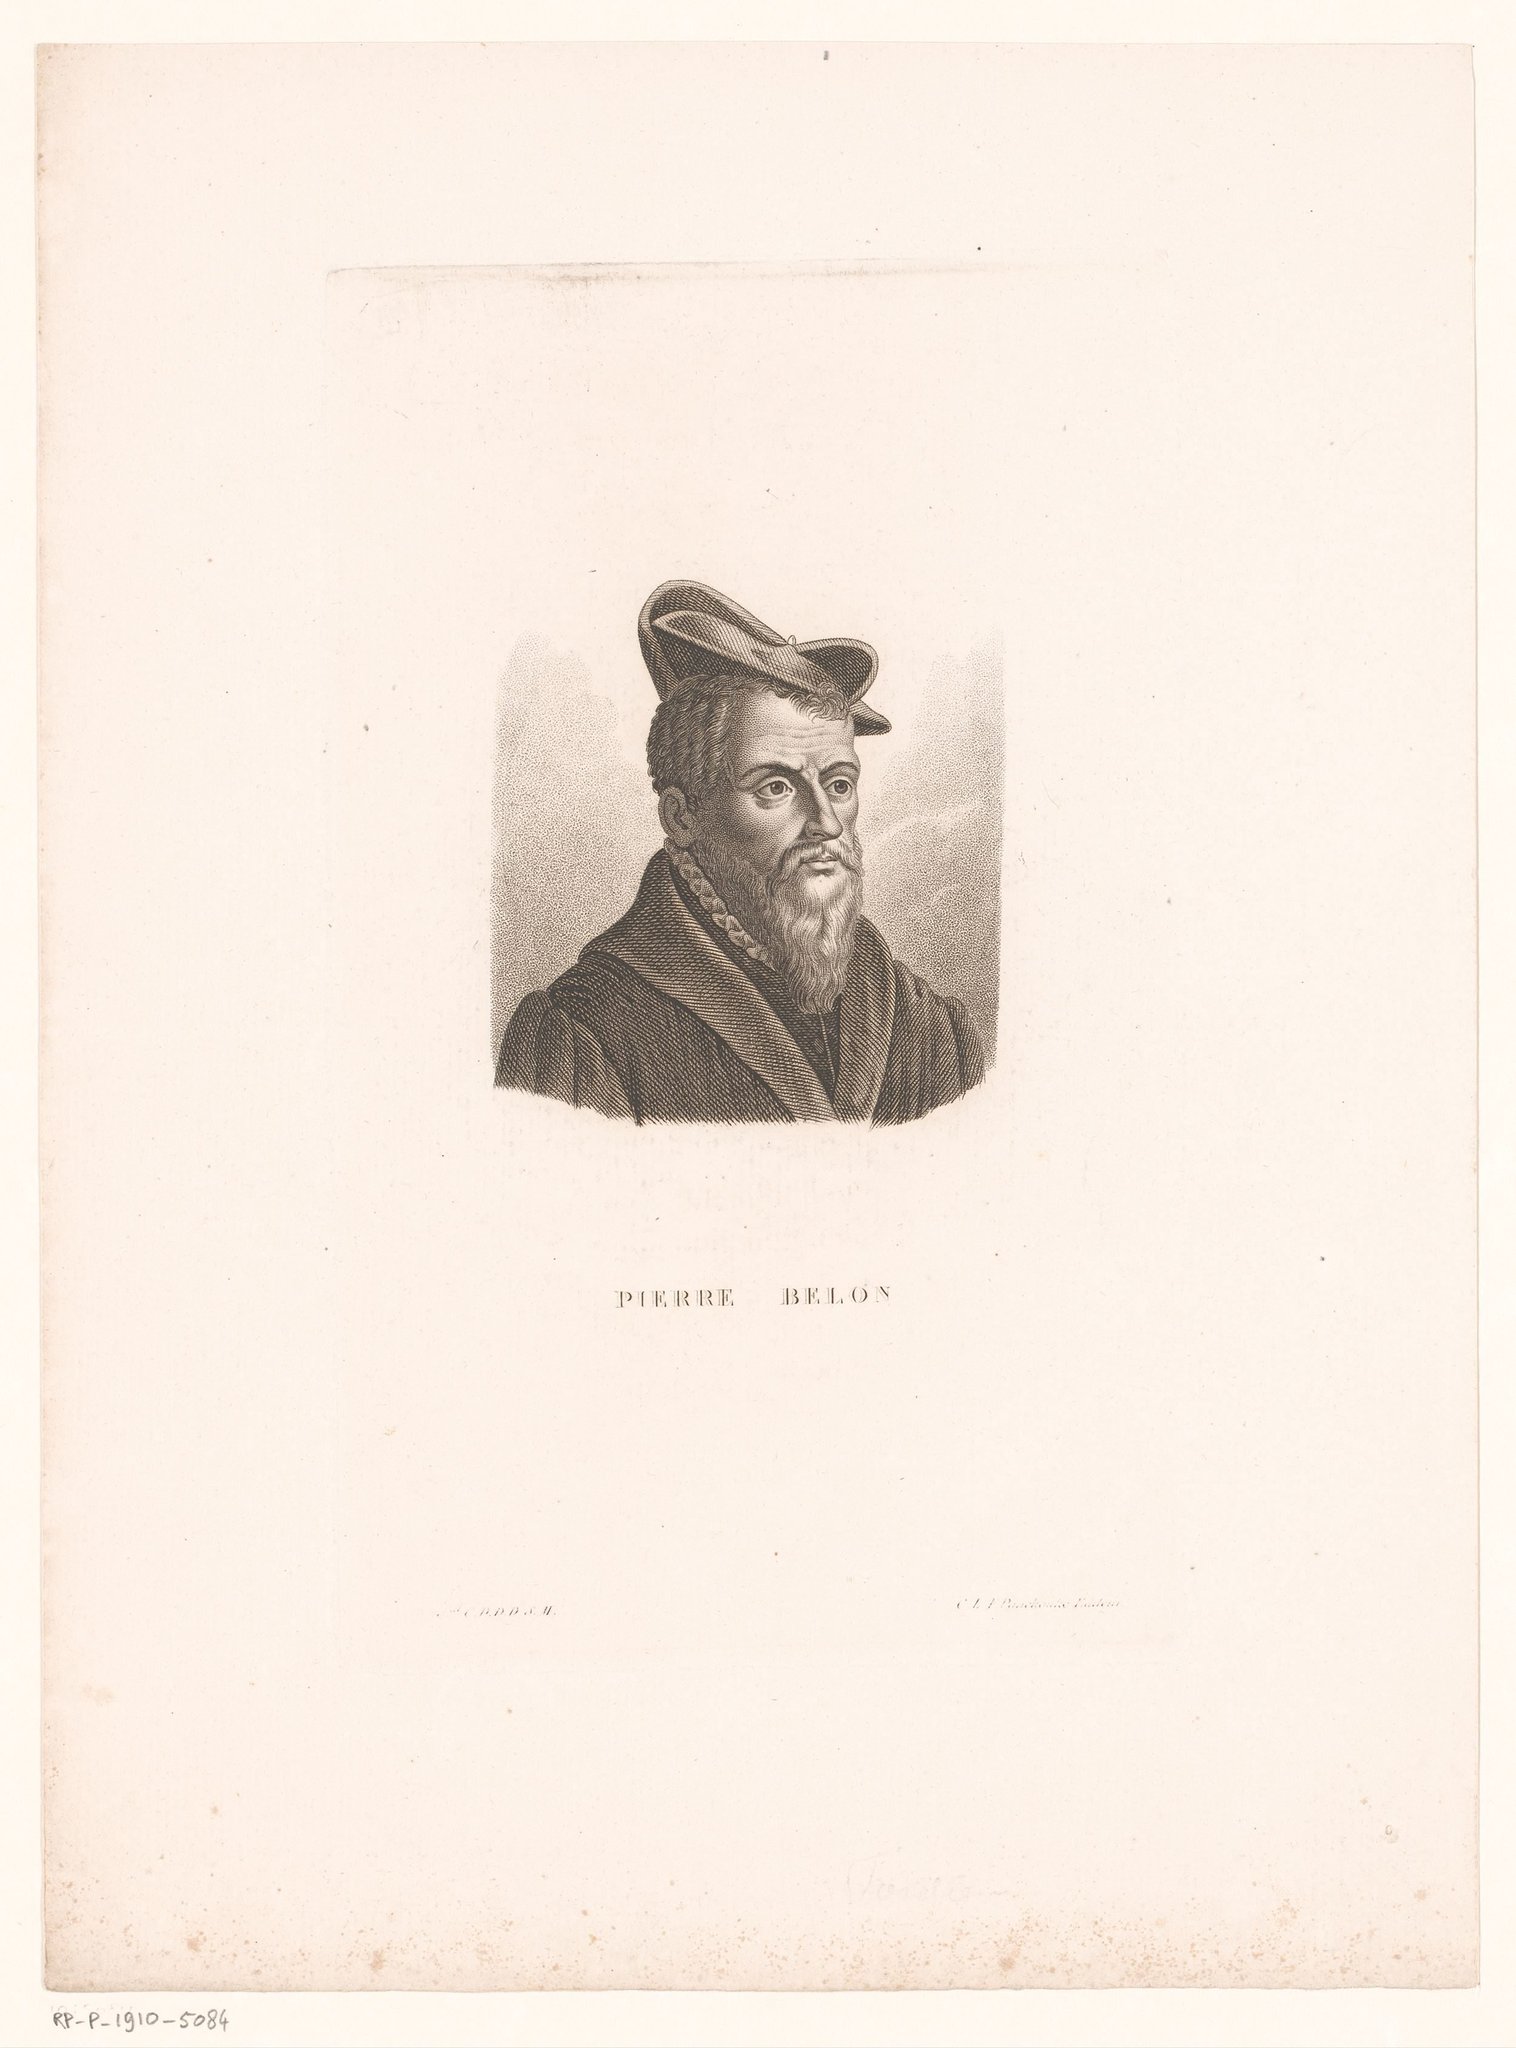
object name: book illustration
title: Portret van Pierre Belon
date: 1818-1832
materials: paper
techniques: engraving, roulette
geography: paris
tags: physicist, scholar, philosopher, historical persons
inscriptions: collector's mark: Lugt 2228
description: Prent uit: Journal complémentaire du Dictionnaire des sciences médicales. Parijs: Panckoucke, Charles Louis Fleury, 1818-1832.